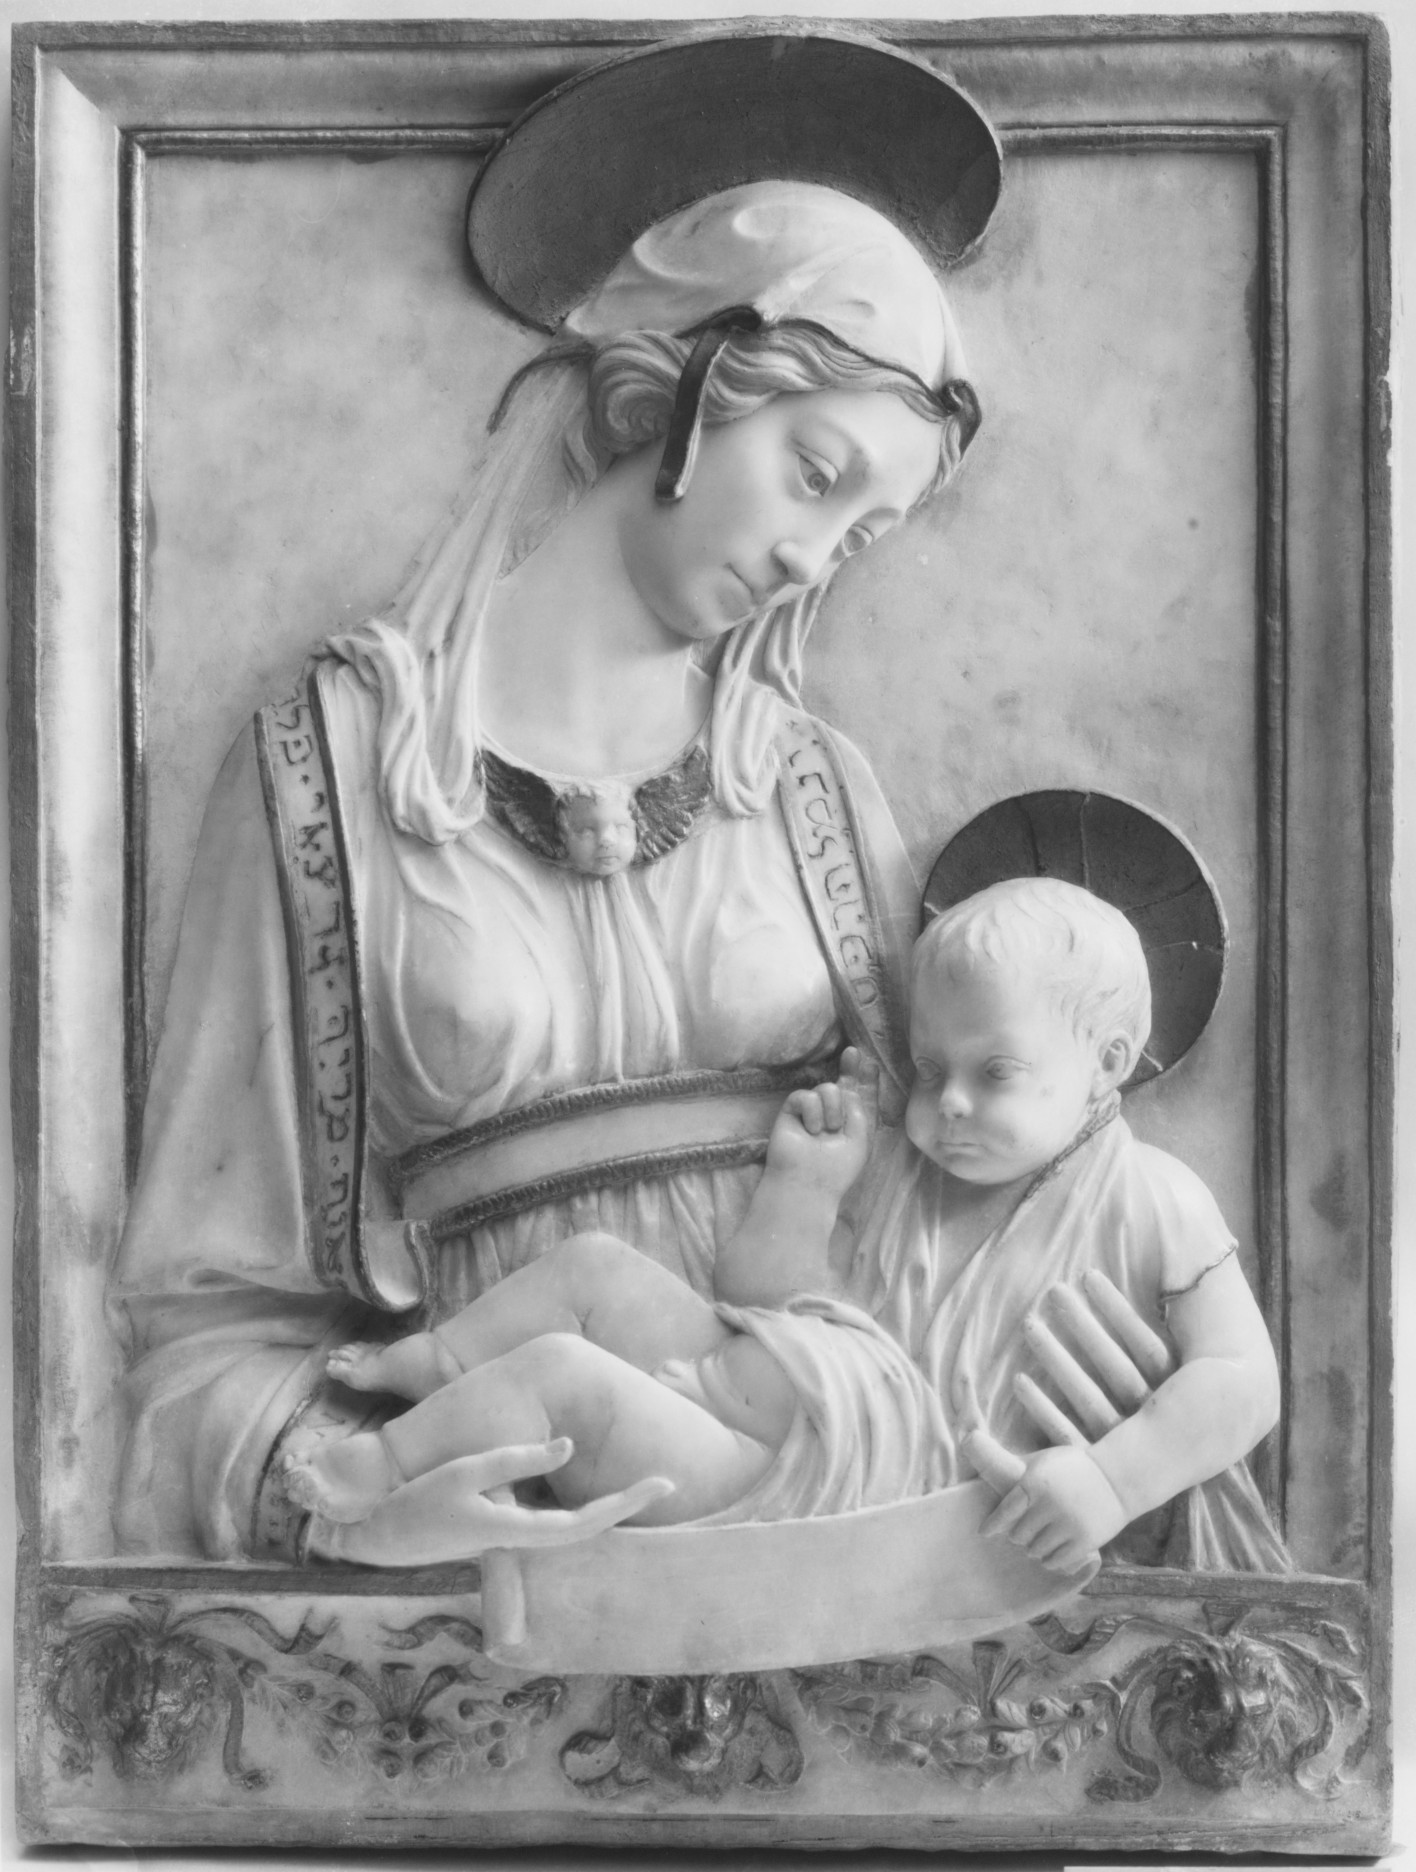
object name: relief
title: Renaissance-style relief of Virgin and Child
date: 1801-1900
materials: marble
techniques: gilding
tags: madonna and child